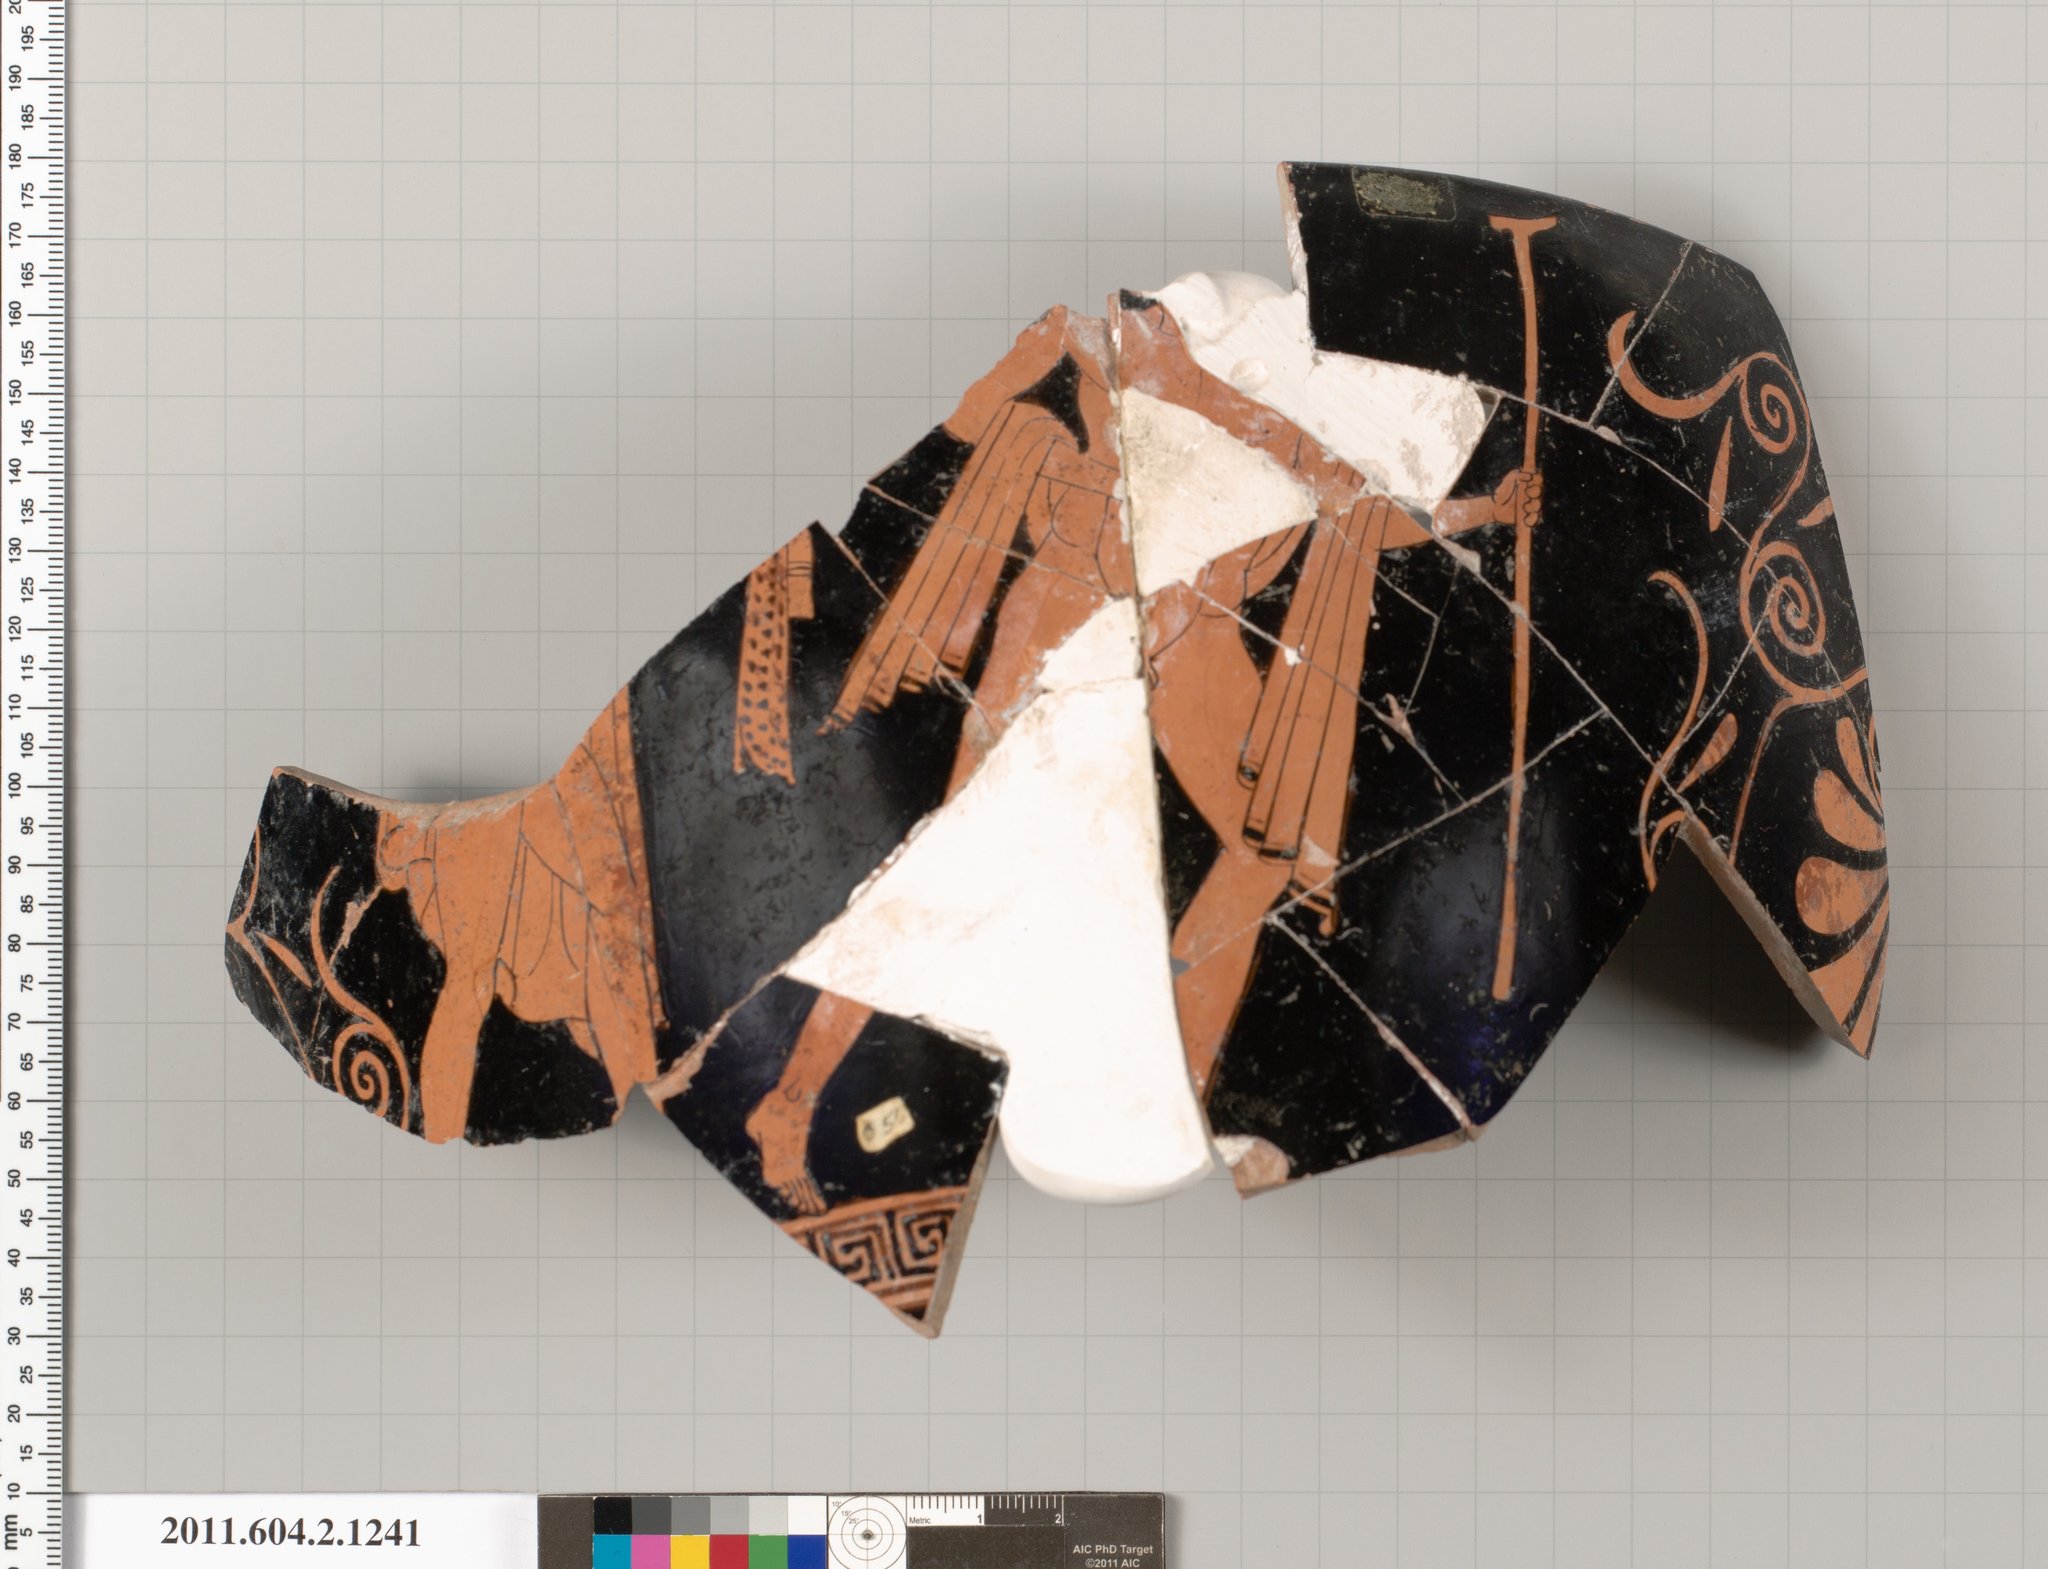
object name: skyphos fragment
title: Terracotta fragment of a skyphos (deep drinking cup)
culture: greek, attic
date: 490-480 BCE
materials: terracotta